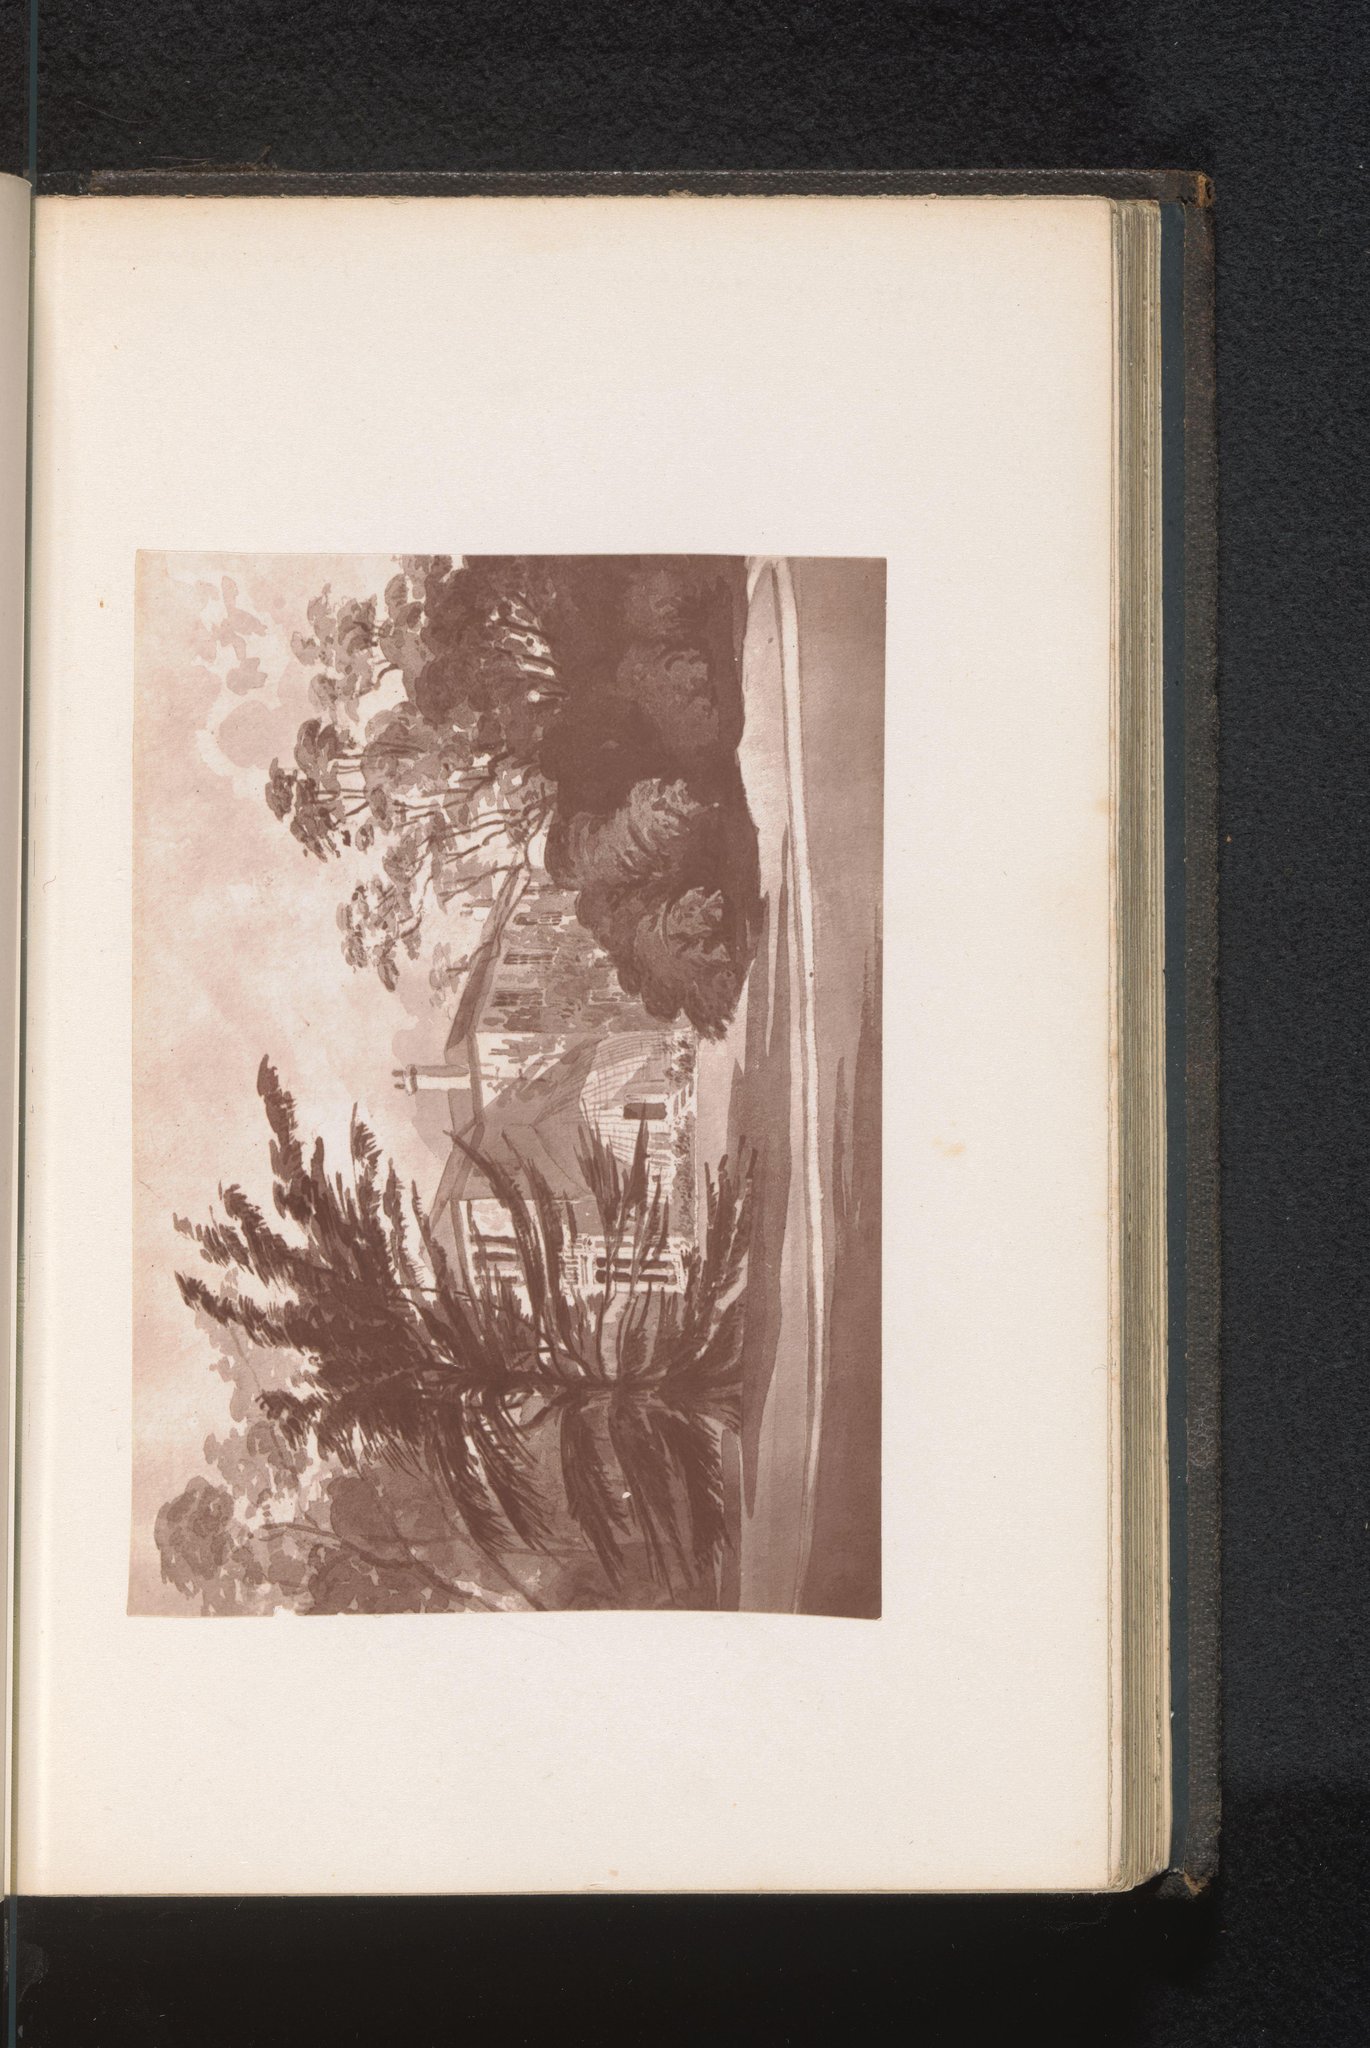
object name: photomechanical print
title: Fotoreproductie van een schildering, voorstellende een gezicht op de pastorie van Herstmonceux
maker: Anonymous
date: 1866-1876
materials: paper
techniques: woodburytype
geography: herstmonceux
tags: housing, façade (of house or building)